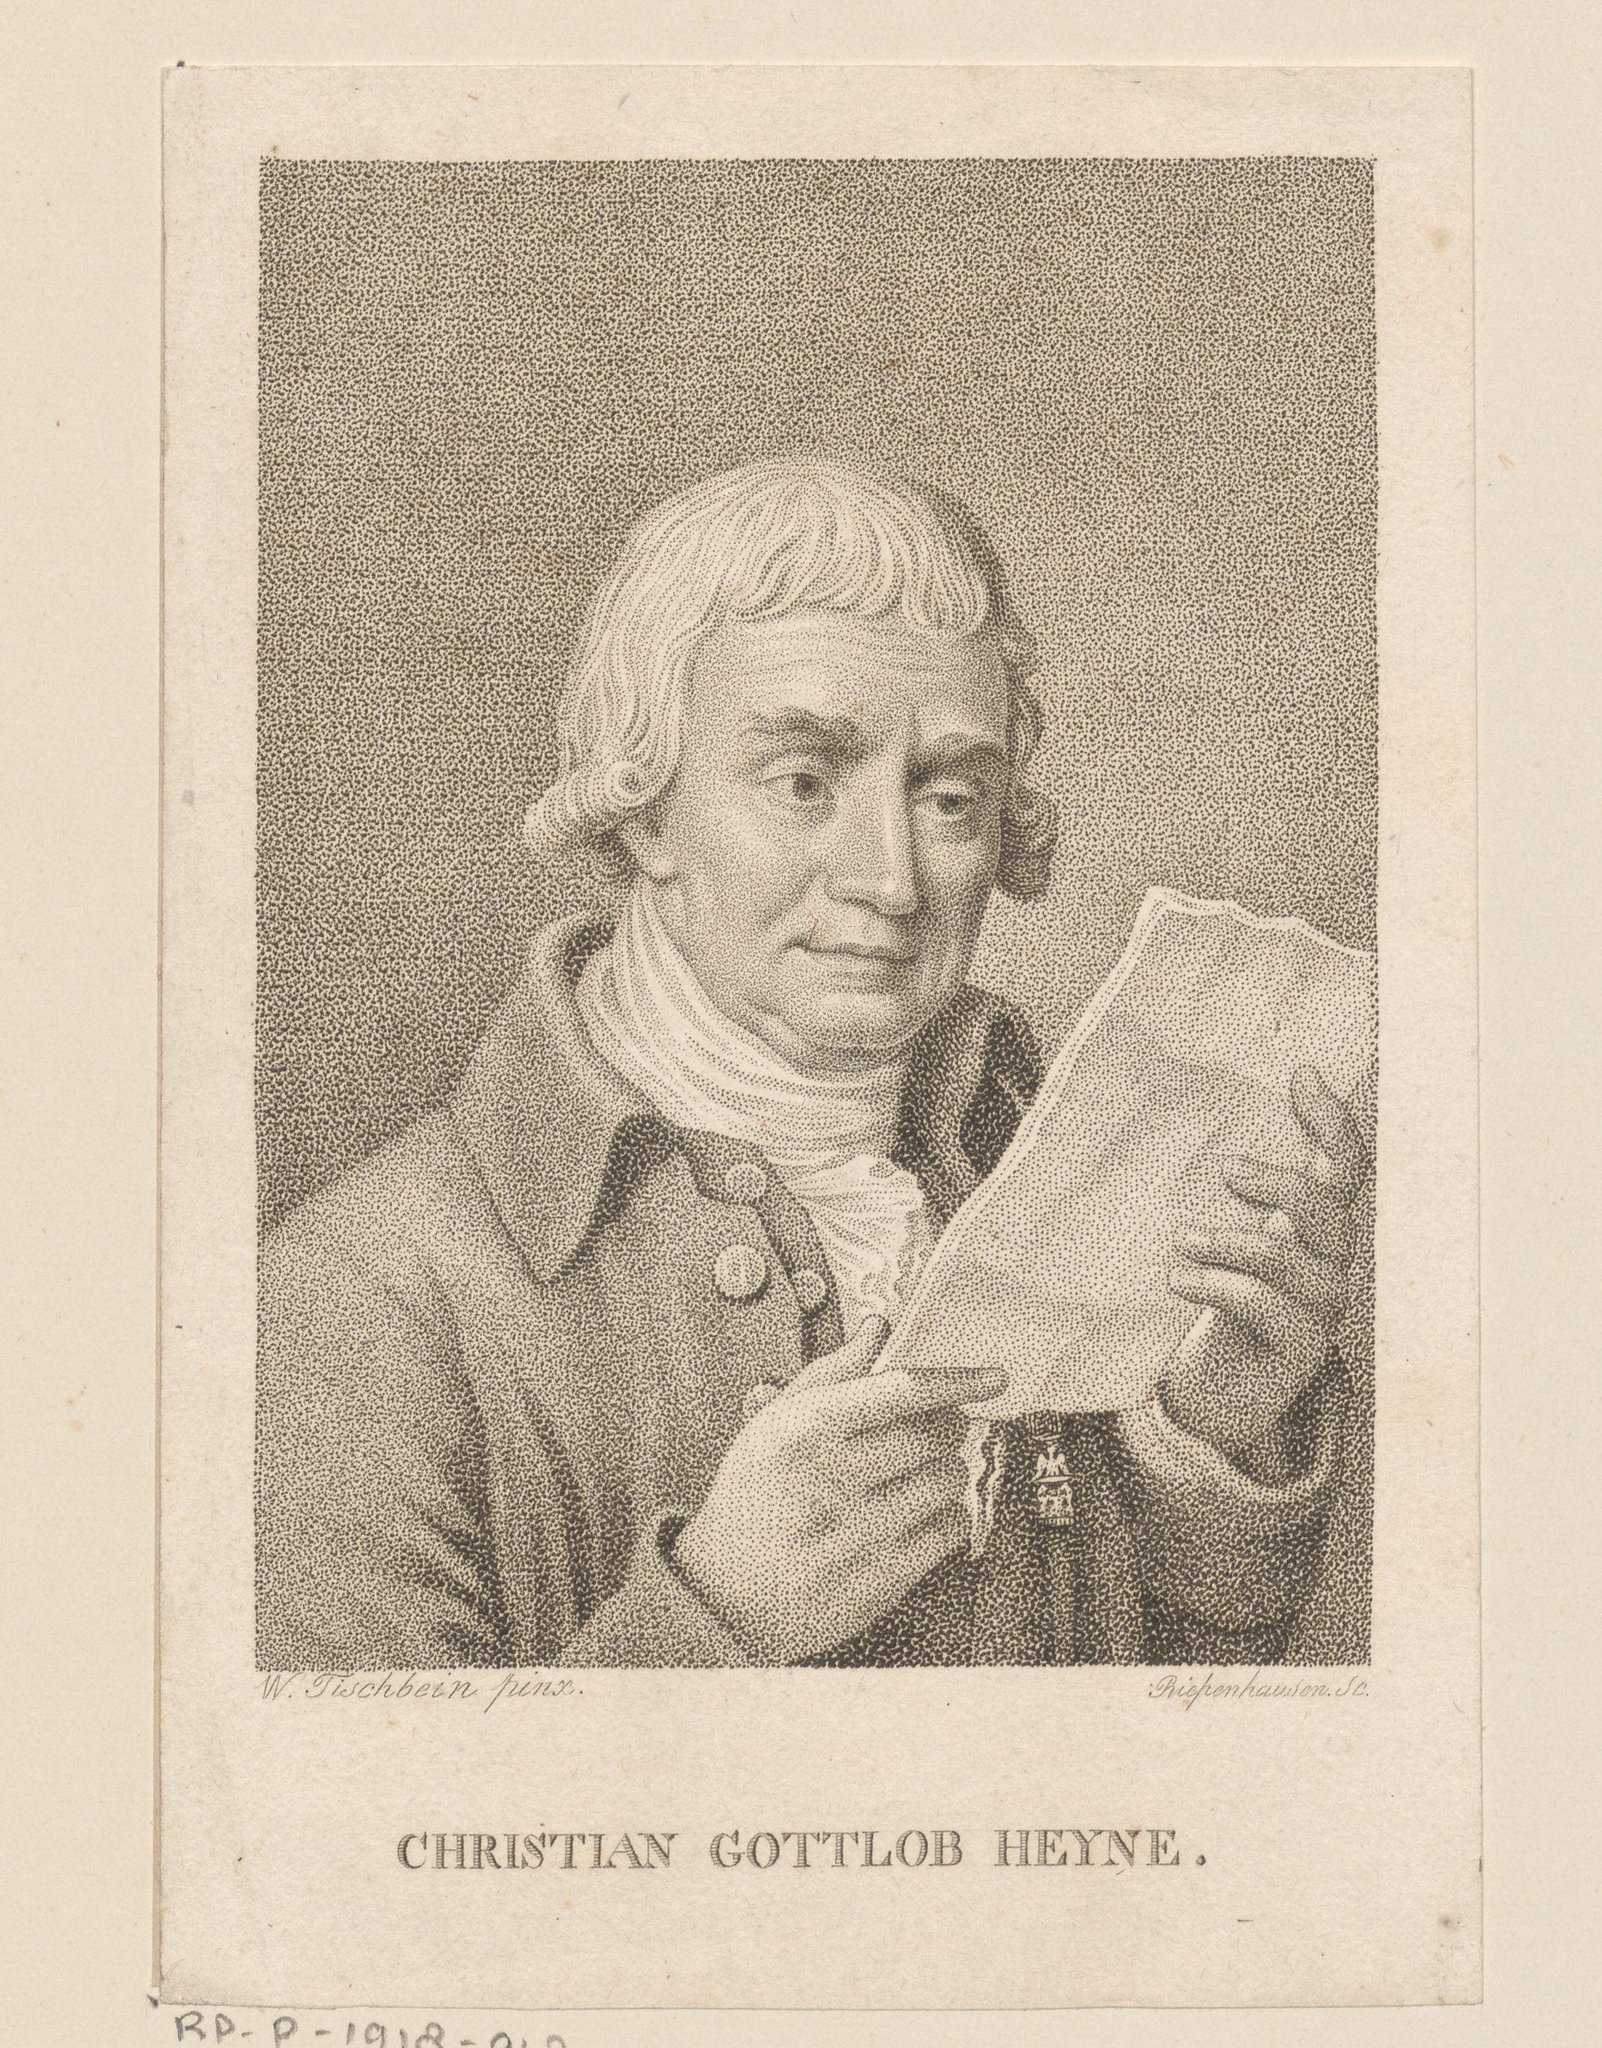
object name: print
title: Portret van Christian Gottlob Heyne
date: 1775-1840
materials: paper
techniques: etching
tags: chemnitz, scholar, philosopher, historical persons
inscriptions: collector's mark: Lugt 2233